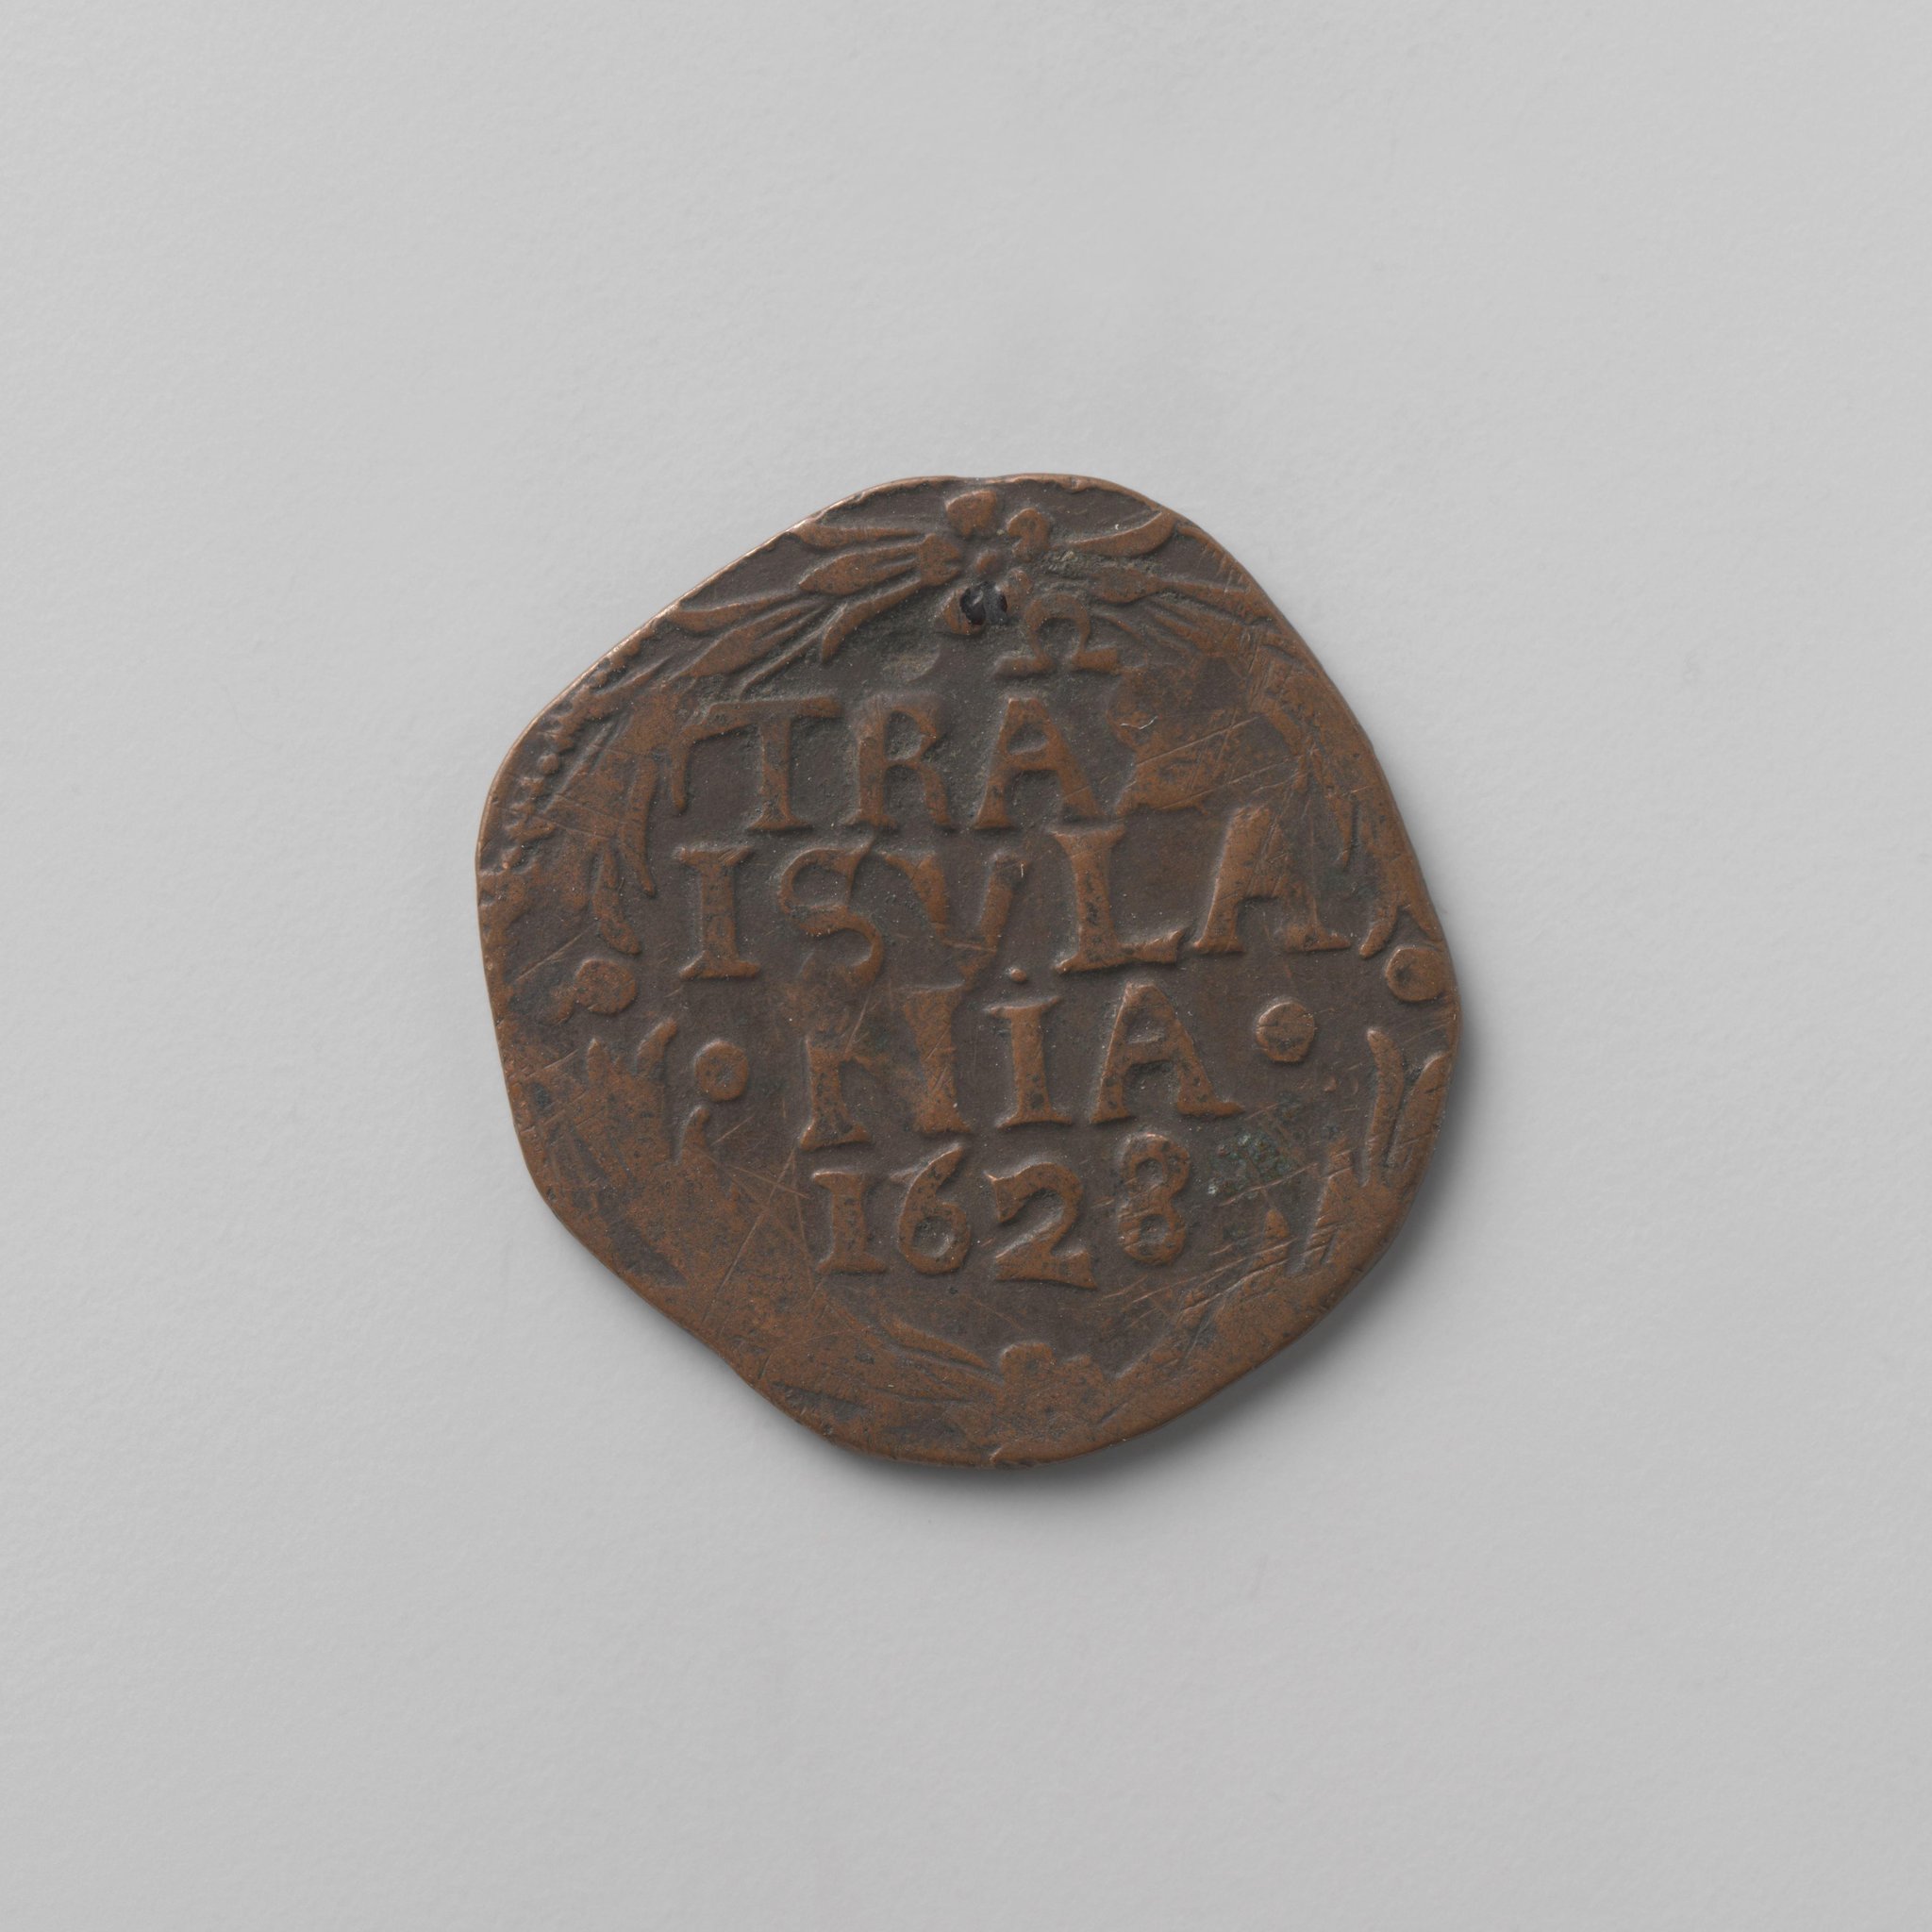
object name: coin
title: Overijsselse duit, 1628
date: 1628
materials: copper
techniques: striking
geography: kampen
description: Zilveren munt. Voorzijde: binnen lauwerkrans drieregelig opschrift, waaronder jaartal. Keerzijde: binnen lauwerkrans gekroond provinciaal wapenschild.